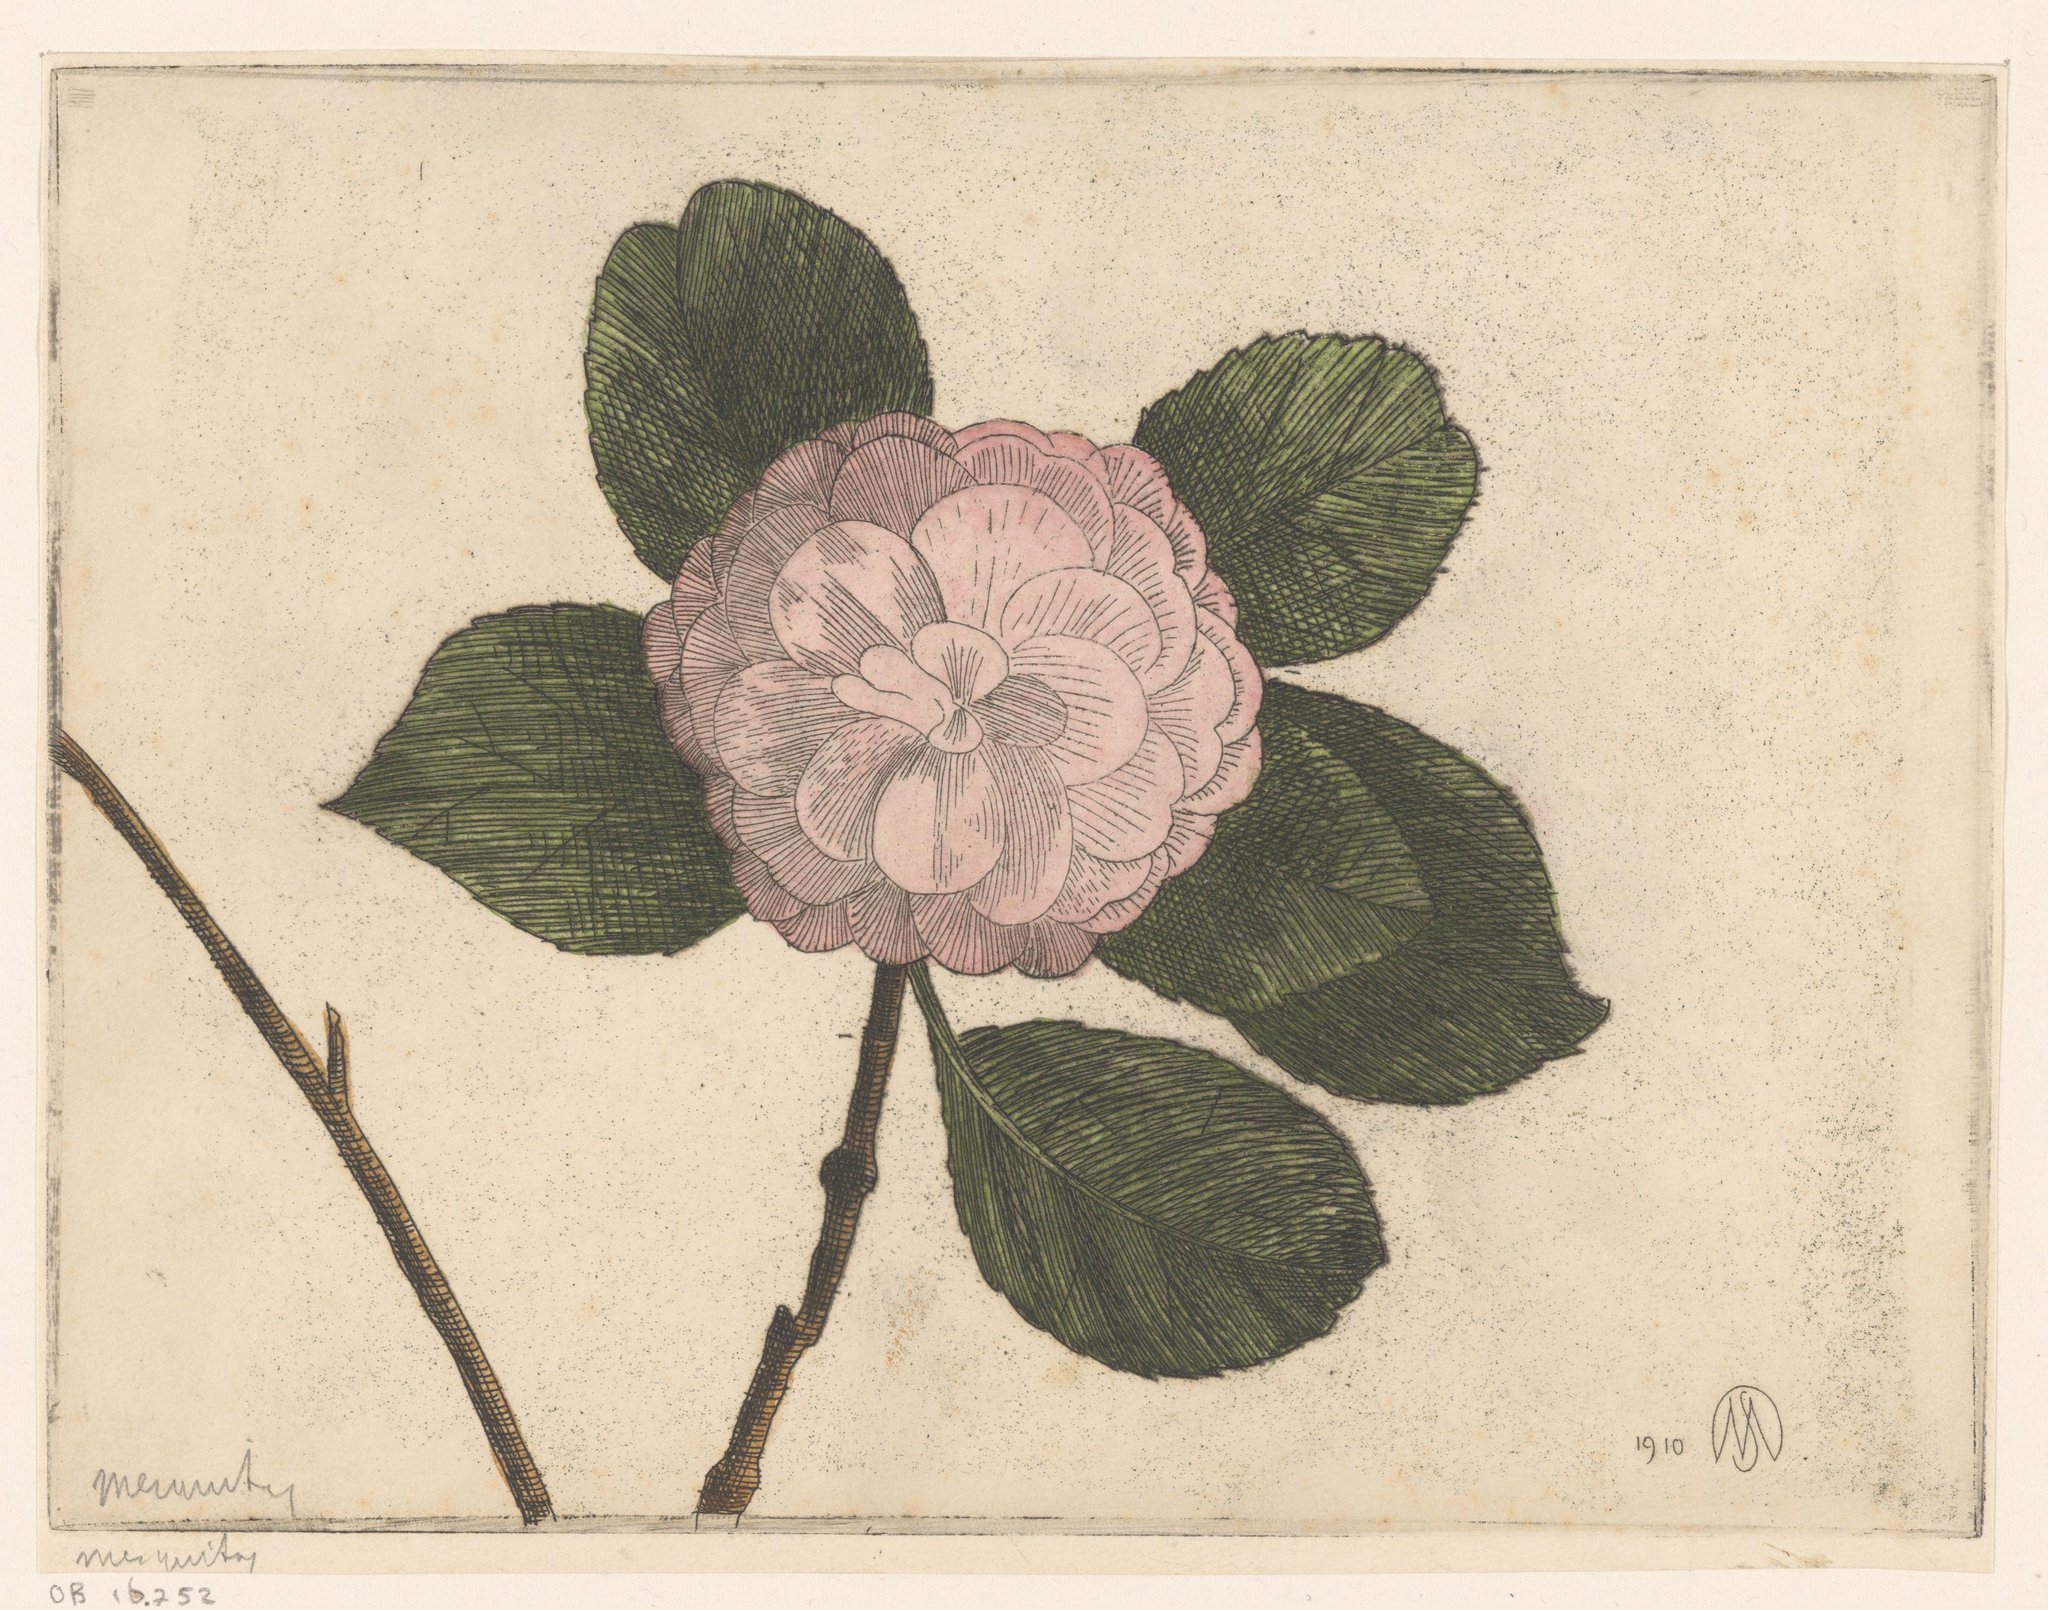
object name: print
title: Camelia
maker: samuel jessurun de mesquita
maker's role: draughtsman, print maker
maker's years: 1868-1944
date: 1910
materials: paper, watercolor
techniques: etching, hand coloring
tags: flowers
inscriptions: date